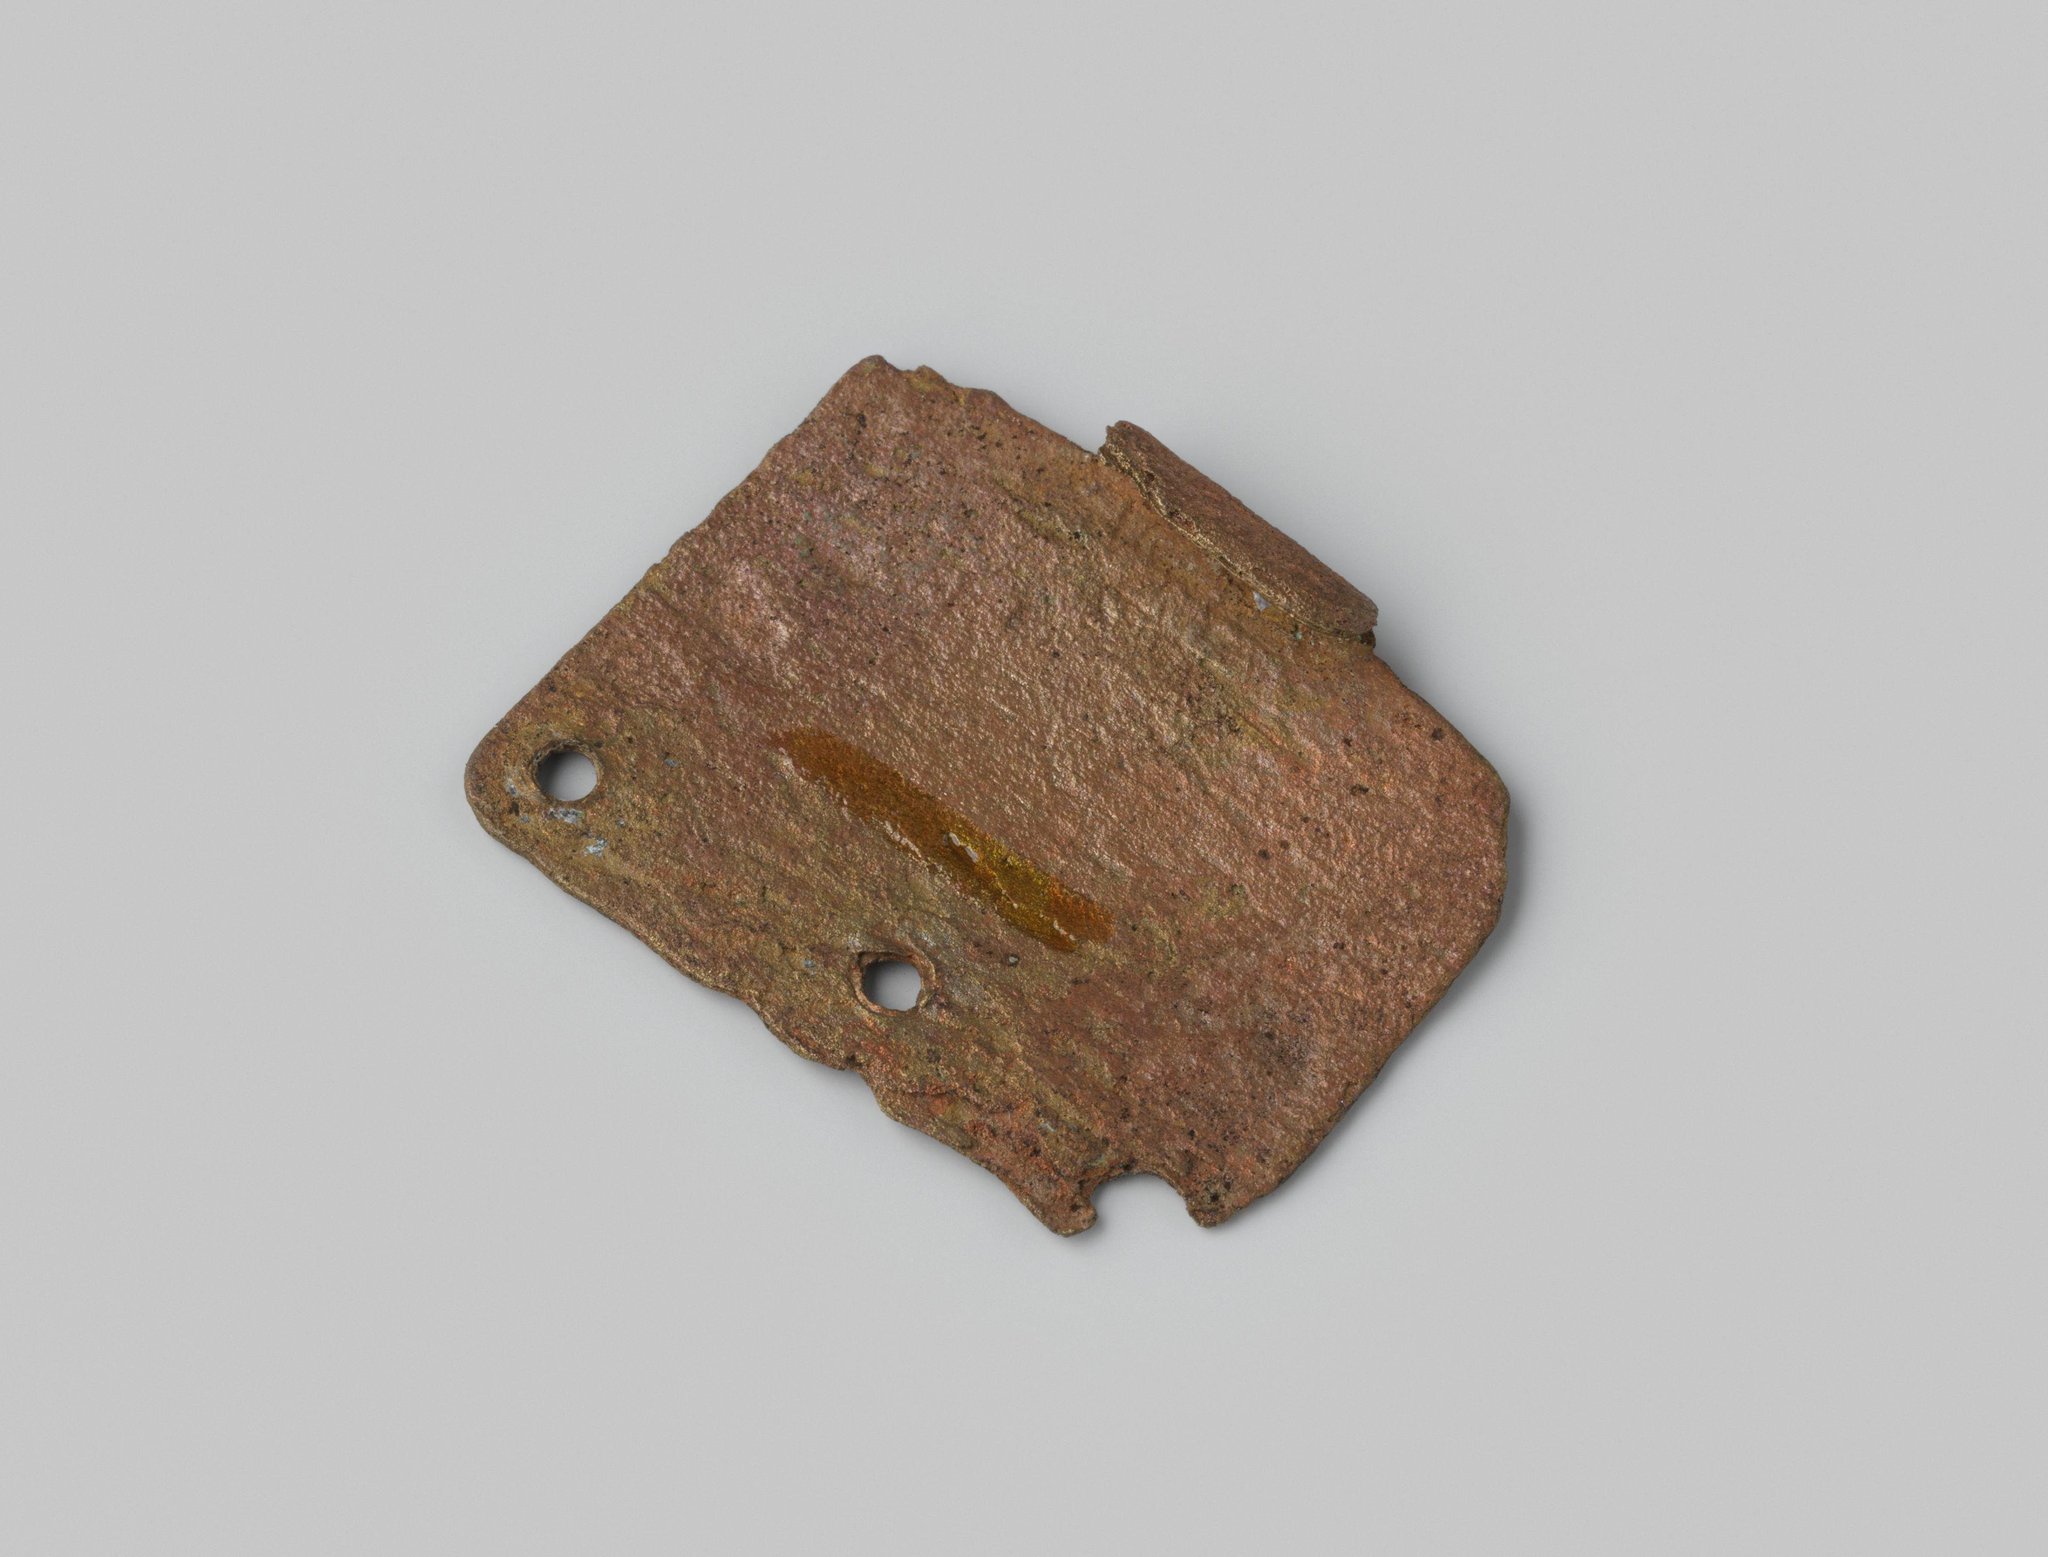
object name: clasp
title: Sluithaak uit het wrak van de Oost-Indiëvaarder Hollandia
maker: Anonymous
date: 1700-1743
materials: copper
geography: netherlands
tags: verenigde oostindische compagnie, hollandia (schip), annet